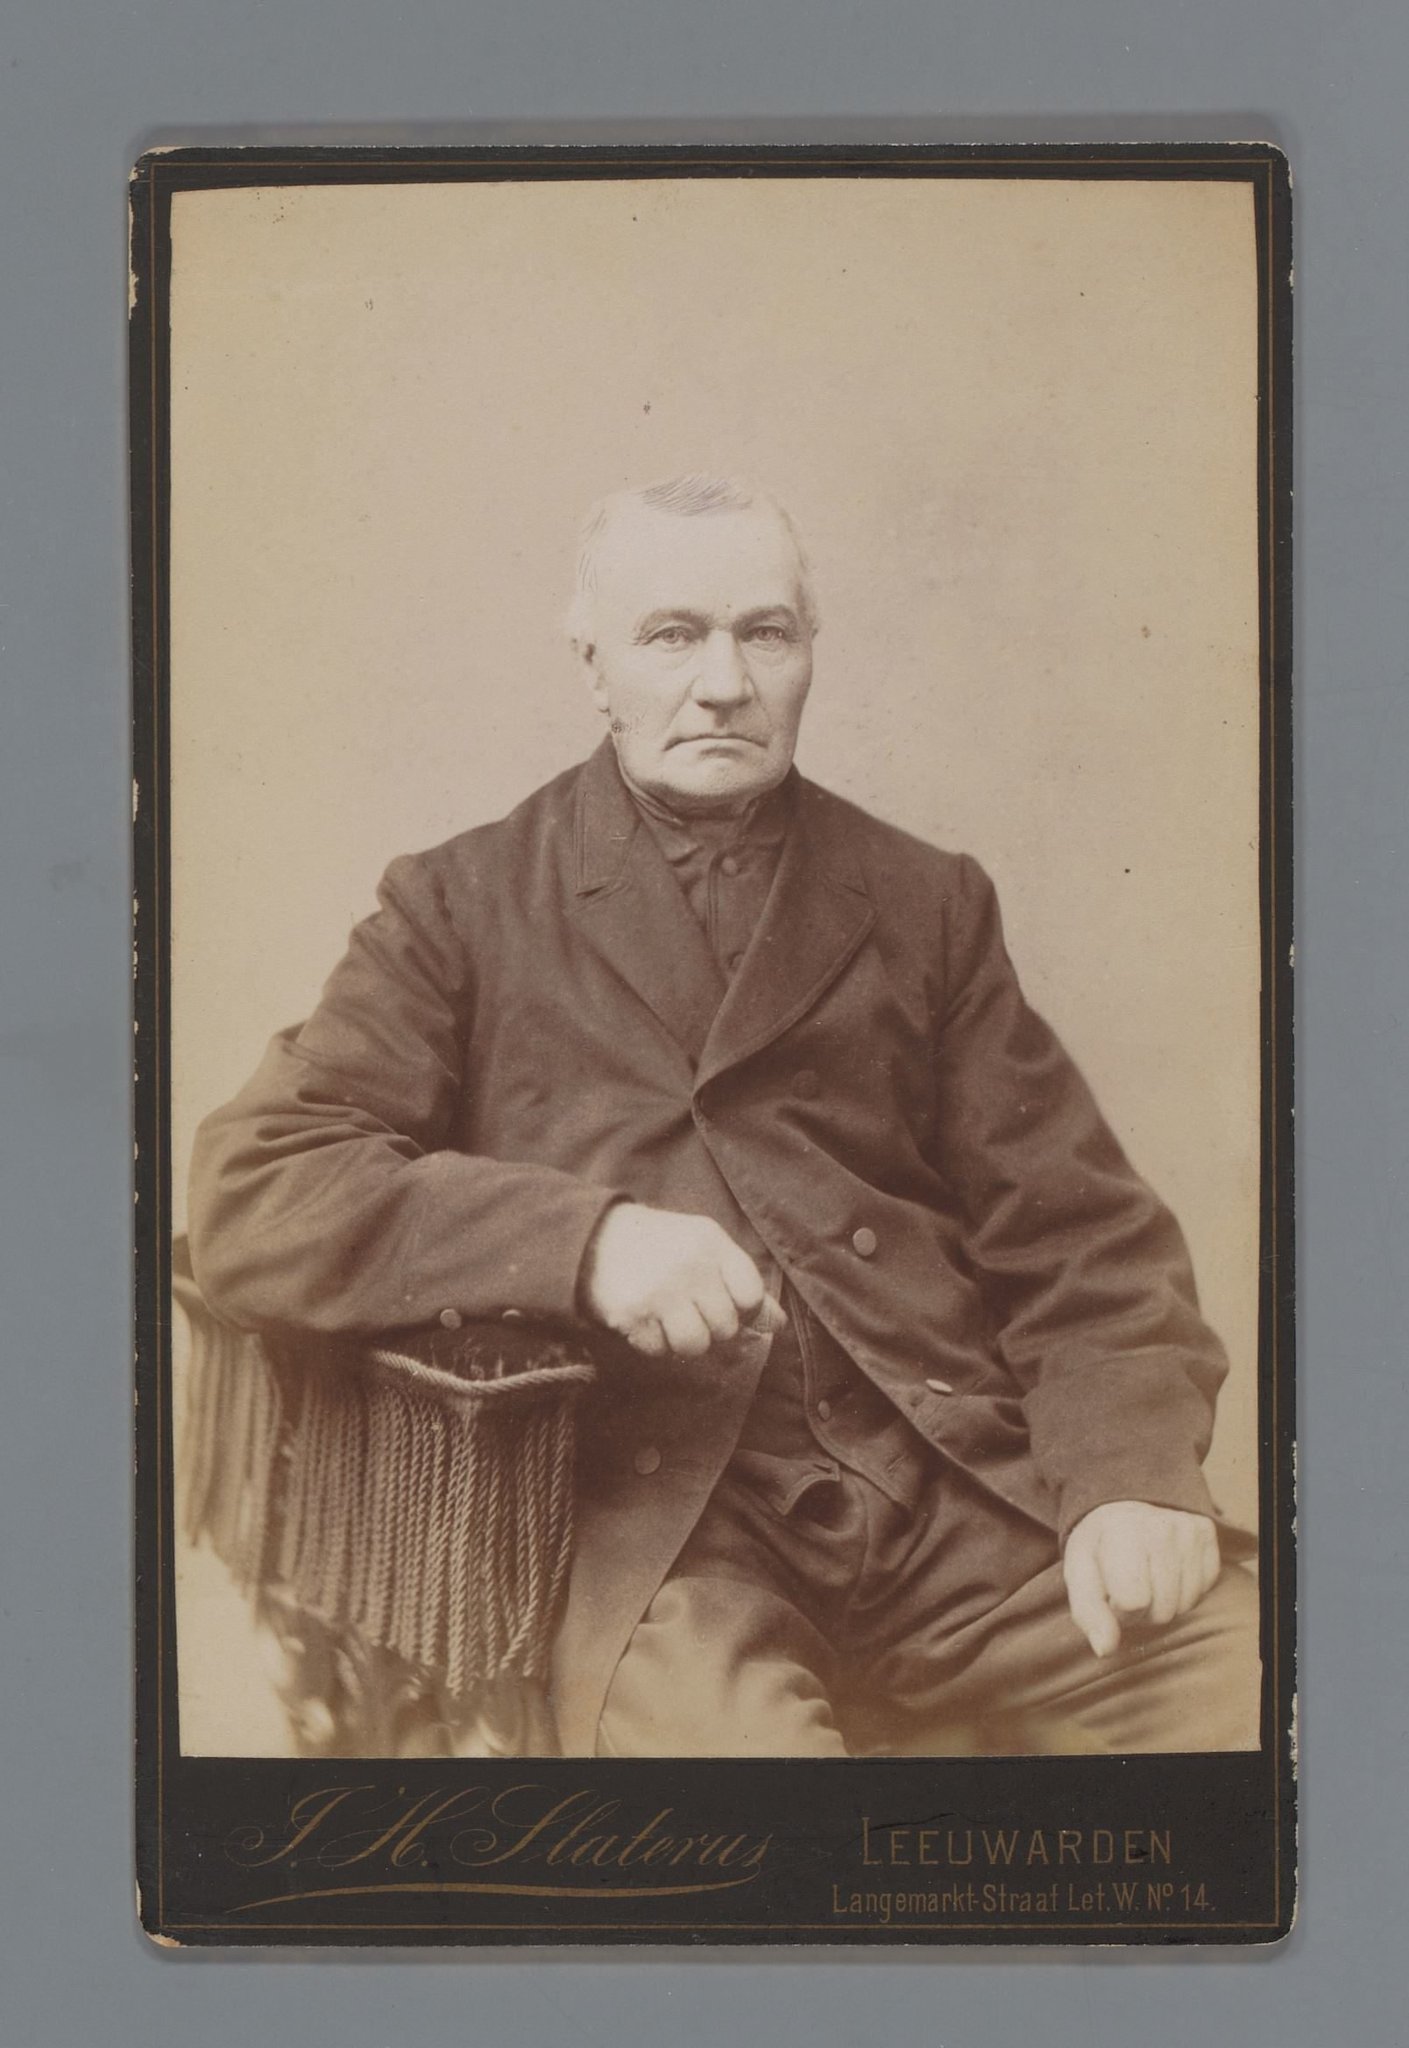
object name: cabinet photograph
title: Portret van een onbekende man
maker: idanus hendrikus slaterus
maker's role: fotograaf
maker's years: 1846-1921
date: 1880-1900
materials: cardboard, photographic support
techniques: albumen print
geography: leeuwarden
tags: old man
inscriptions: inscription: ‘Atelier I. H. Slaterus Leeuwarden Langemarkt-Straat Let. W. No. 14 tegen over het station bij de Nieuwe Veemarkt. Specialiteit in Vergrootingen ’